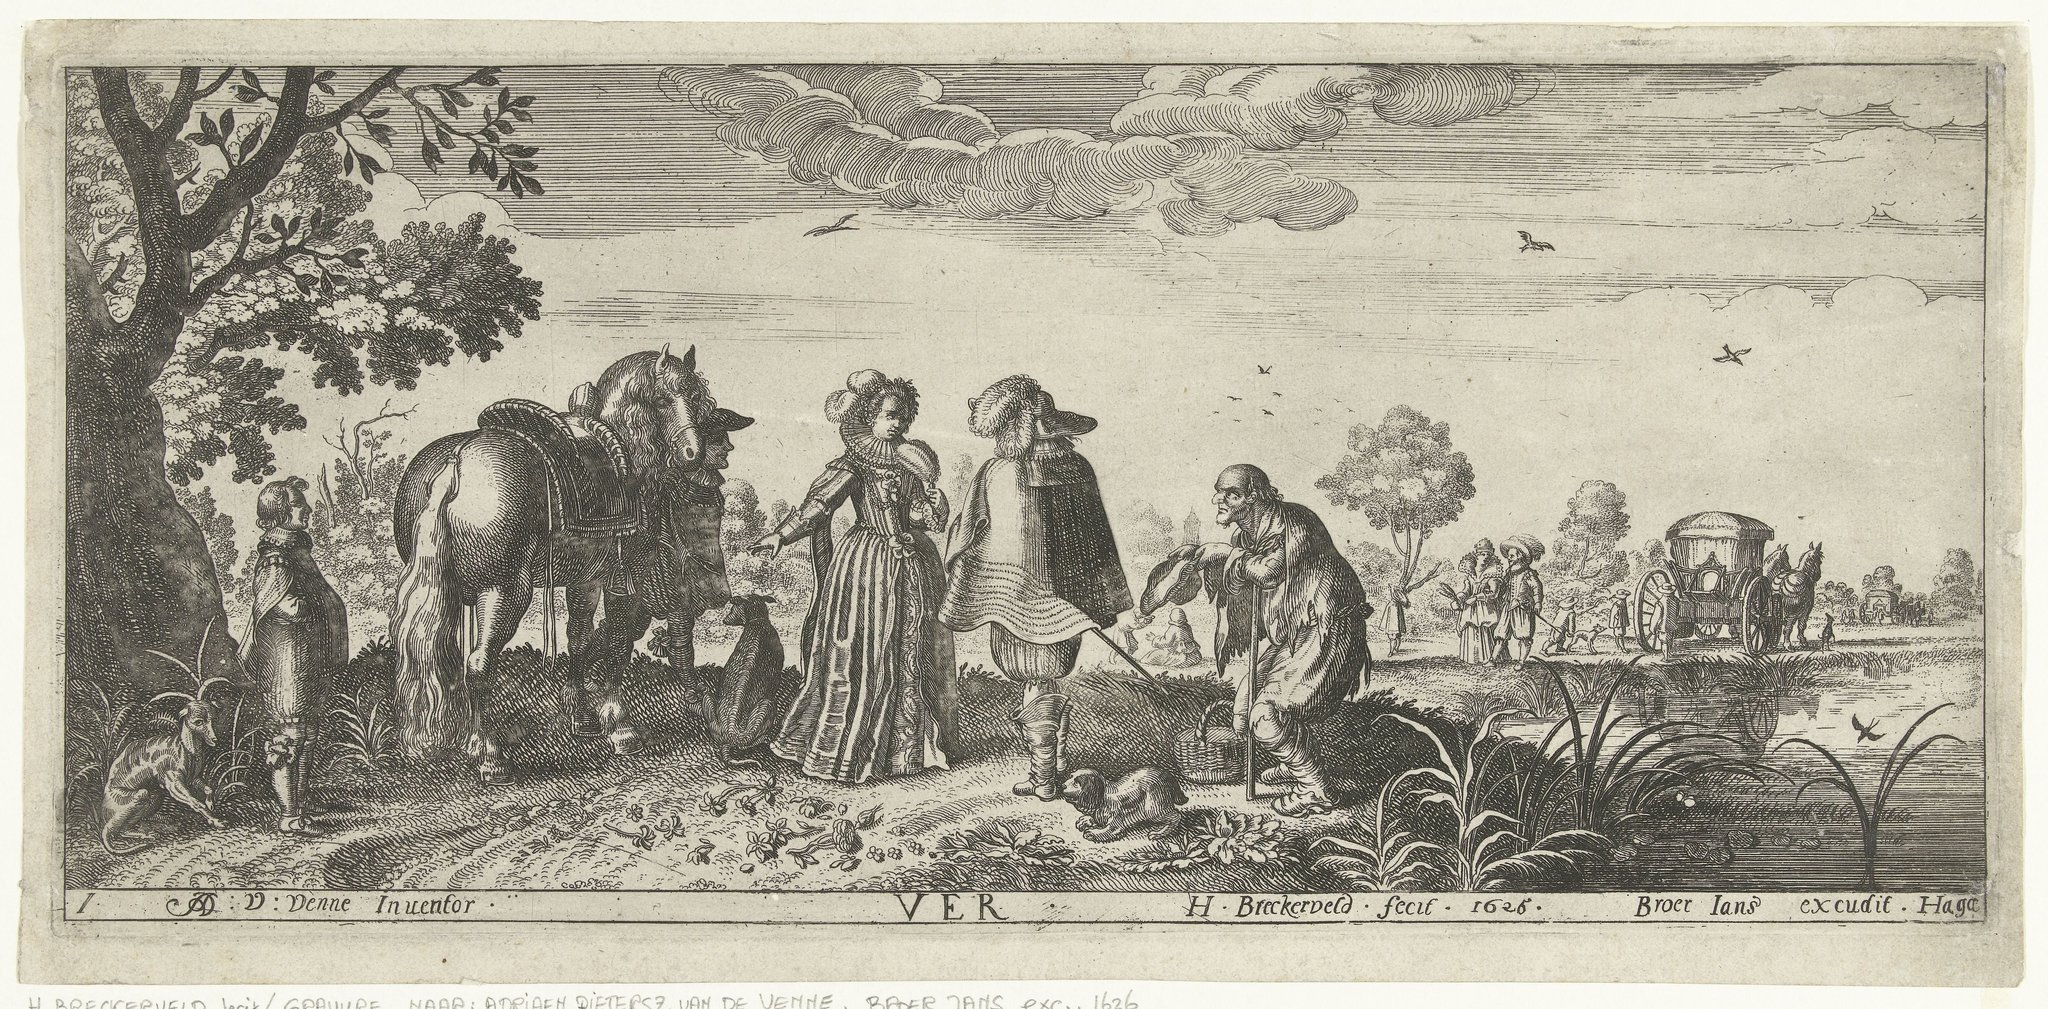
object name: print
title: De vier seizoenen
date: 1626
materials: paper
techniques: engraving, etching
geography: the hague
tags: spring ~ human activities (the four seasons of the year), clothes, costume (+ men's clothes)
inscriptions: signature and date: ‘H. Breckerveld. fecit 1626’, signature: ‘A.V: Venne Inventor’, collector's mark: Lugt 2228, number: ‘I’, title: ‘VER’, address: ‘Broer Jans excudit Hagae’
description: Een elegant gekleed paar staat bij een paard dat wordt vastgehouden door een bediende. Rechts een bedelaar die hen om een aalmoes vraagt, links een jongeman en een hond. Rechtsachter een koets die langs een vaart rijdt en wandelaars. Voorstelling van de lente uit een serie van vier prenten met de vier seizoenen.